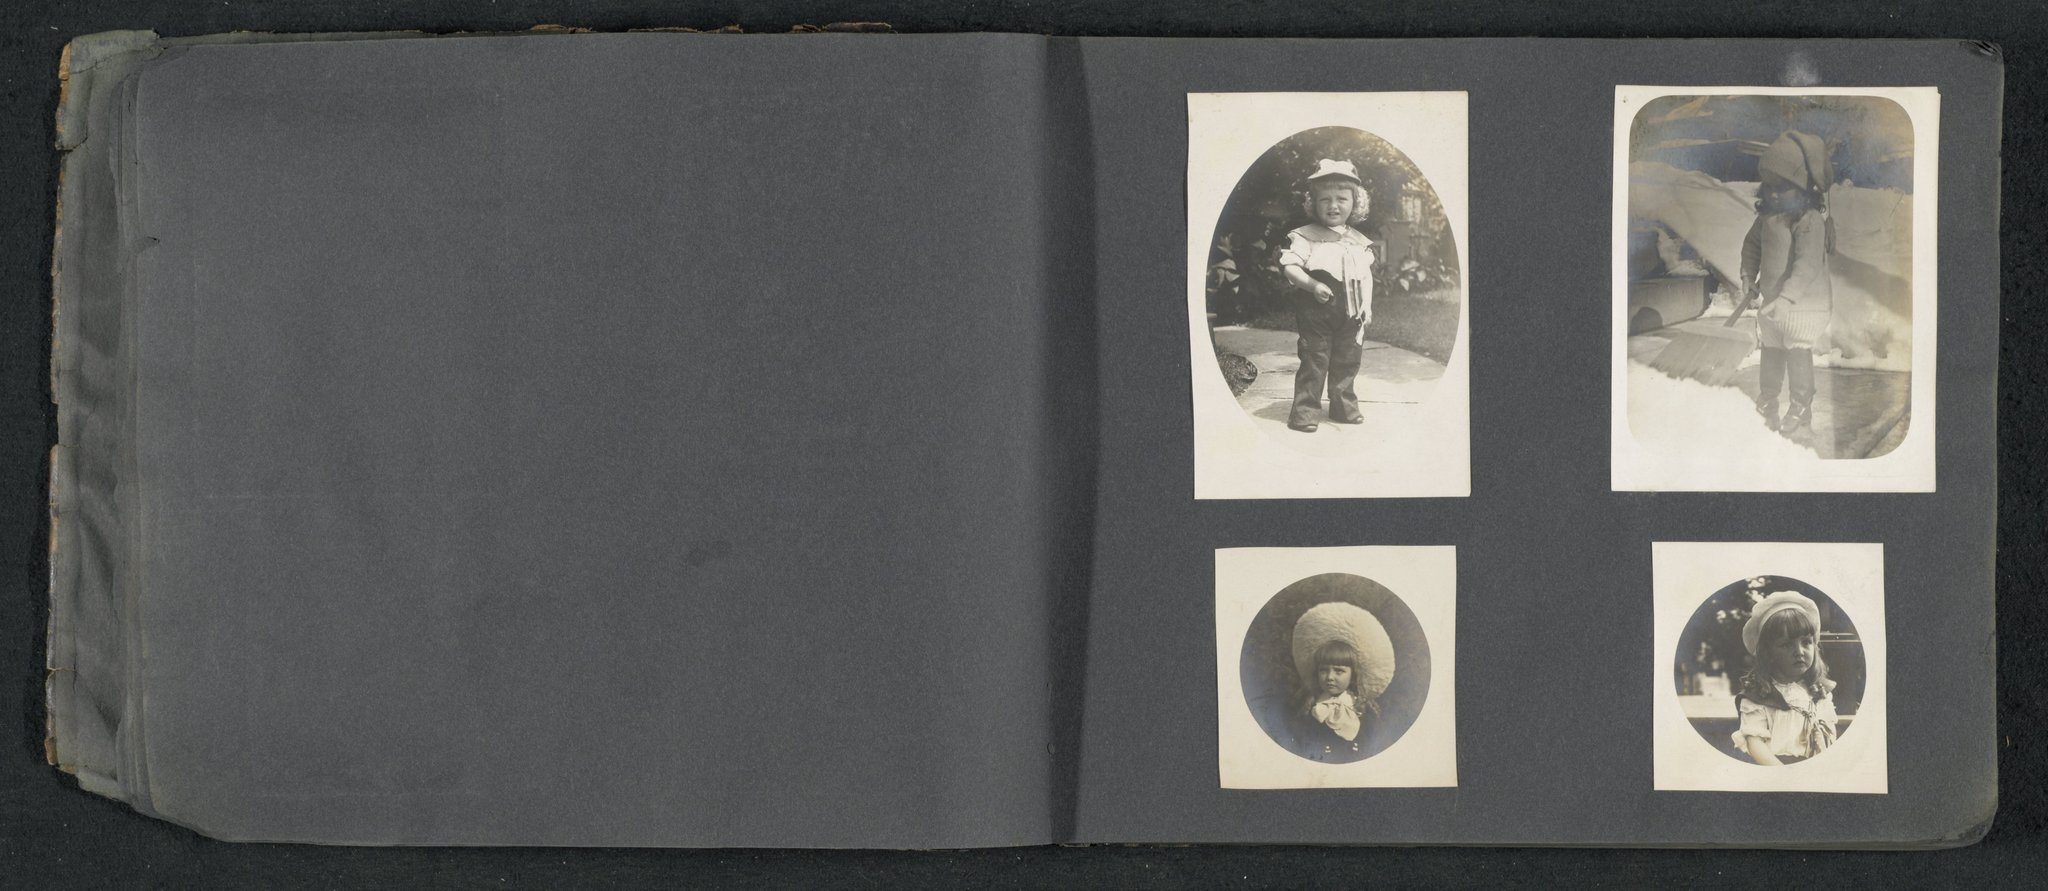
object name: album leaf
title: Kleuters met mutsen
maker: Anonymous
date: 1890-1902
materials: paper, photographic support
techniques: gelatin silver print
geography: united states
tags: historical persons, snow, tot, toddler ~ the ages of man, united states of america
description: Albumblad met vier foto's van kleuters met mutsen, waarvan één in de sneeuw. Onderdeel van Familiealbum met voornamelijk foto's van een jong Amerikaans meisje.